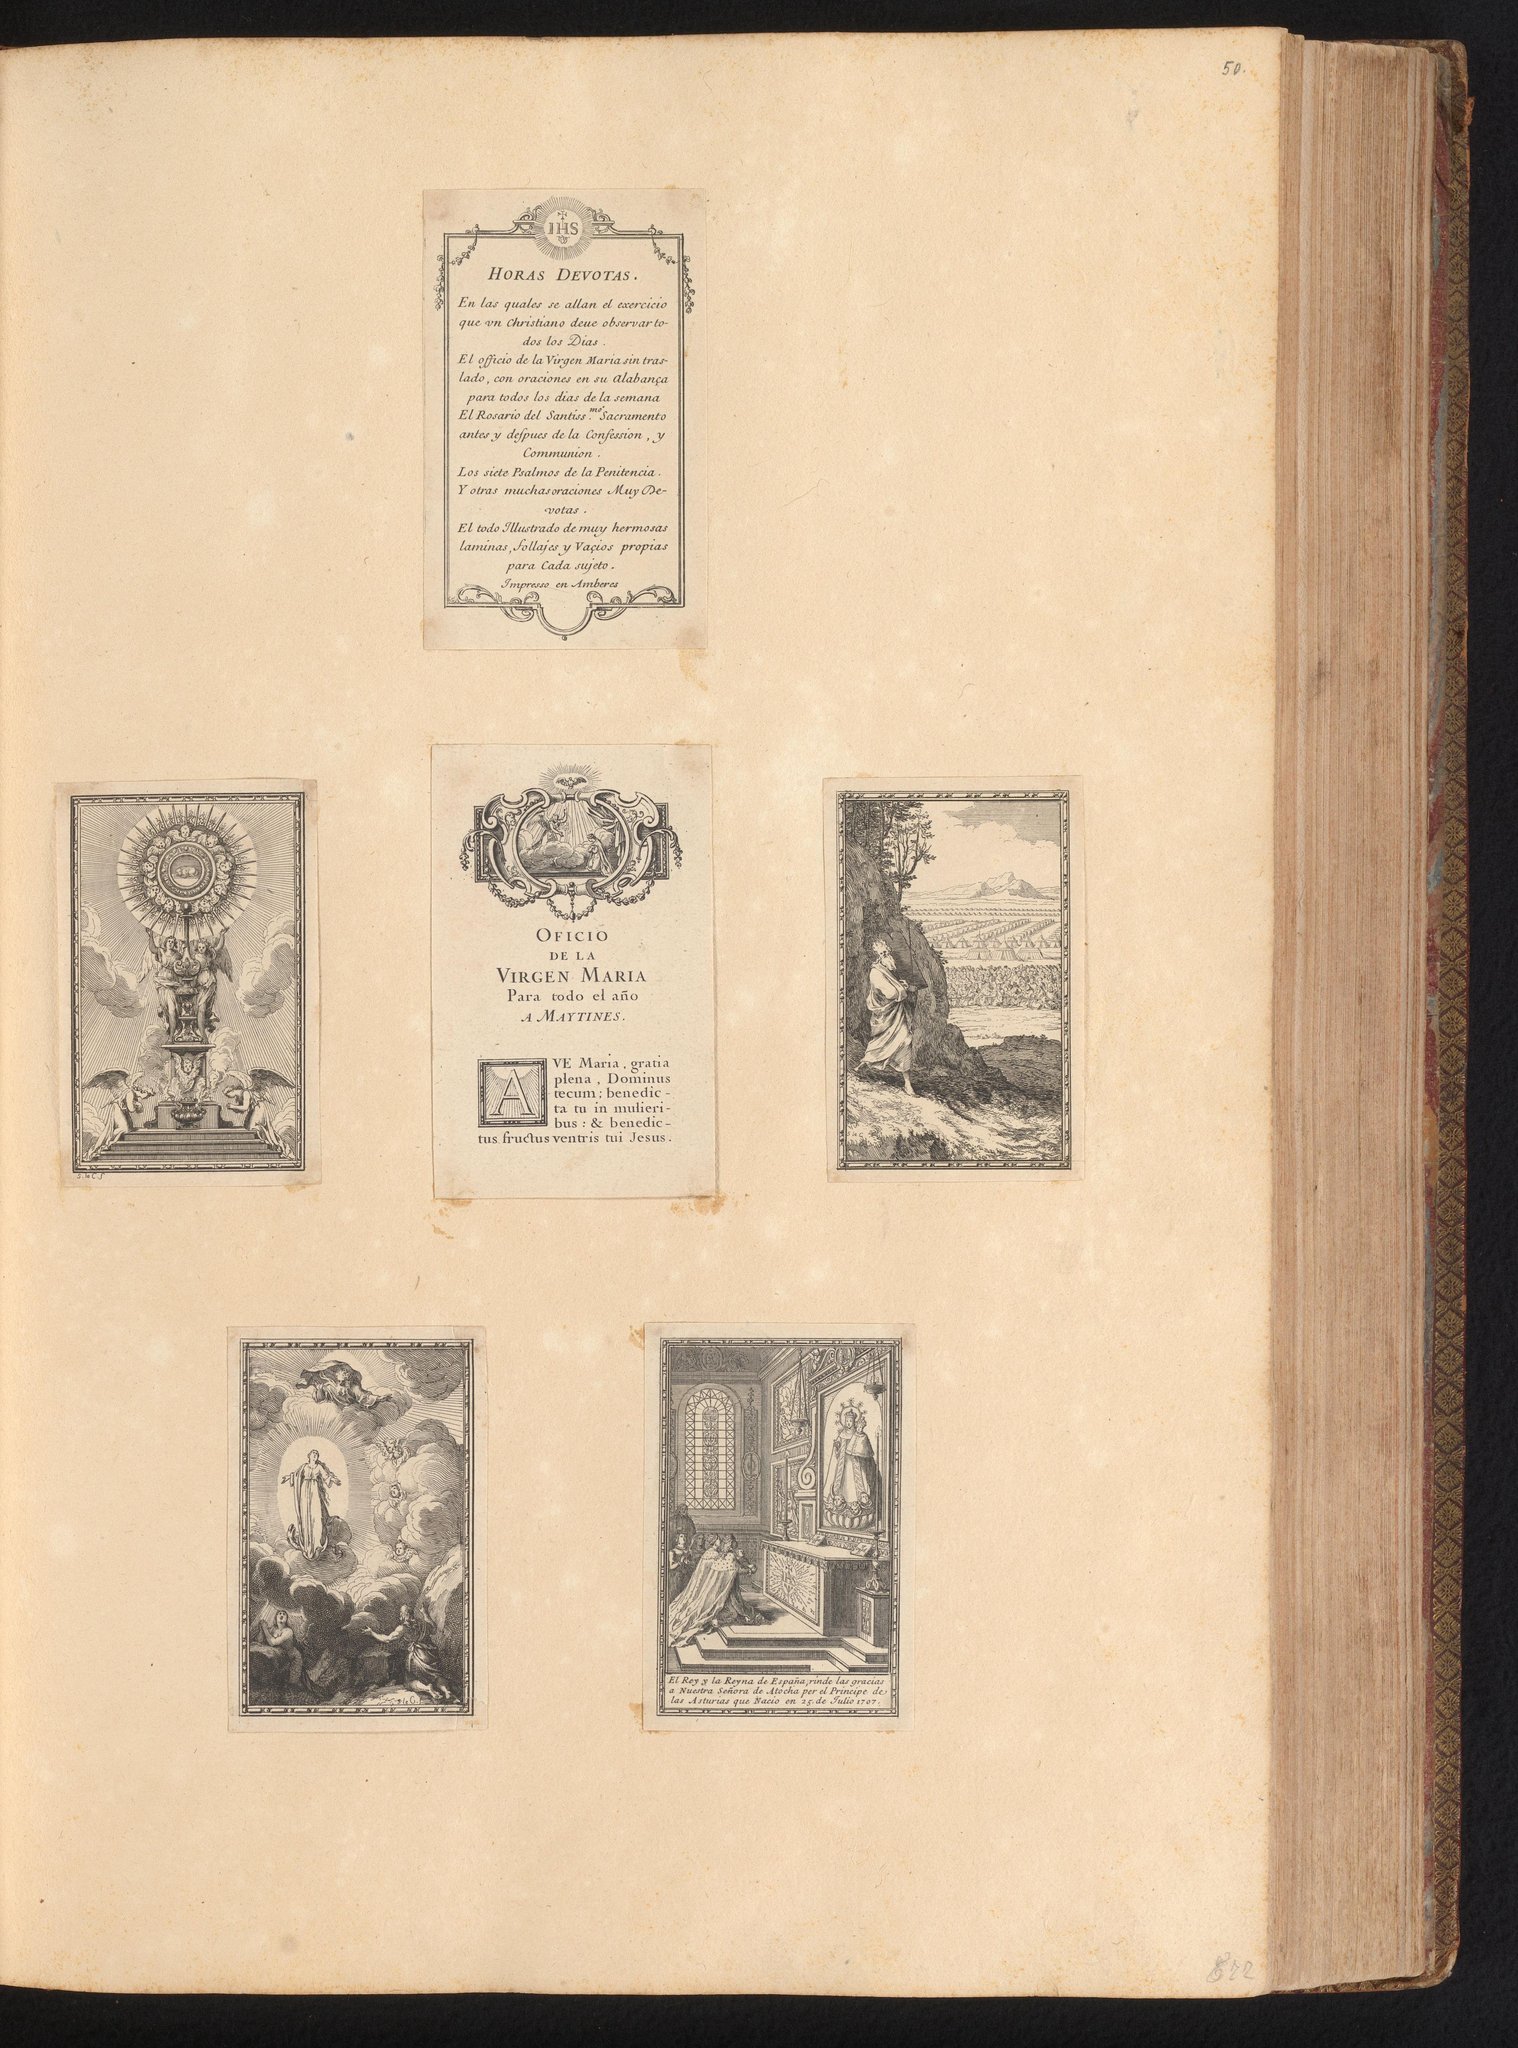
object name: album leaf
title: Zes prenten bedoeld voor een gebedenboek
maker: sébastien leclerc (i)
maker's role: print maker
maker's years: 1637-1714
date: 1710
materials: paper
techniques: engraving, etching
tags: breviary, book of hours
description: Deze zes prenten waren bedoeld voor een Spaans gebedenboek.